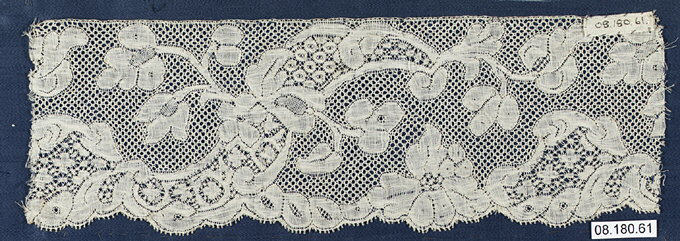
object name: fragment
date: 1801-1900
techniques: lace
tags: flowers,leaves